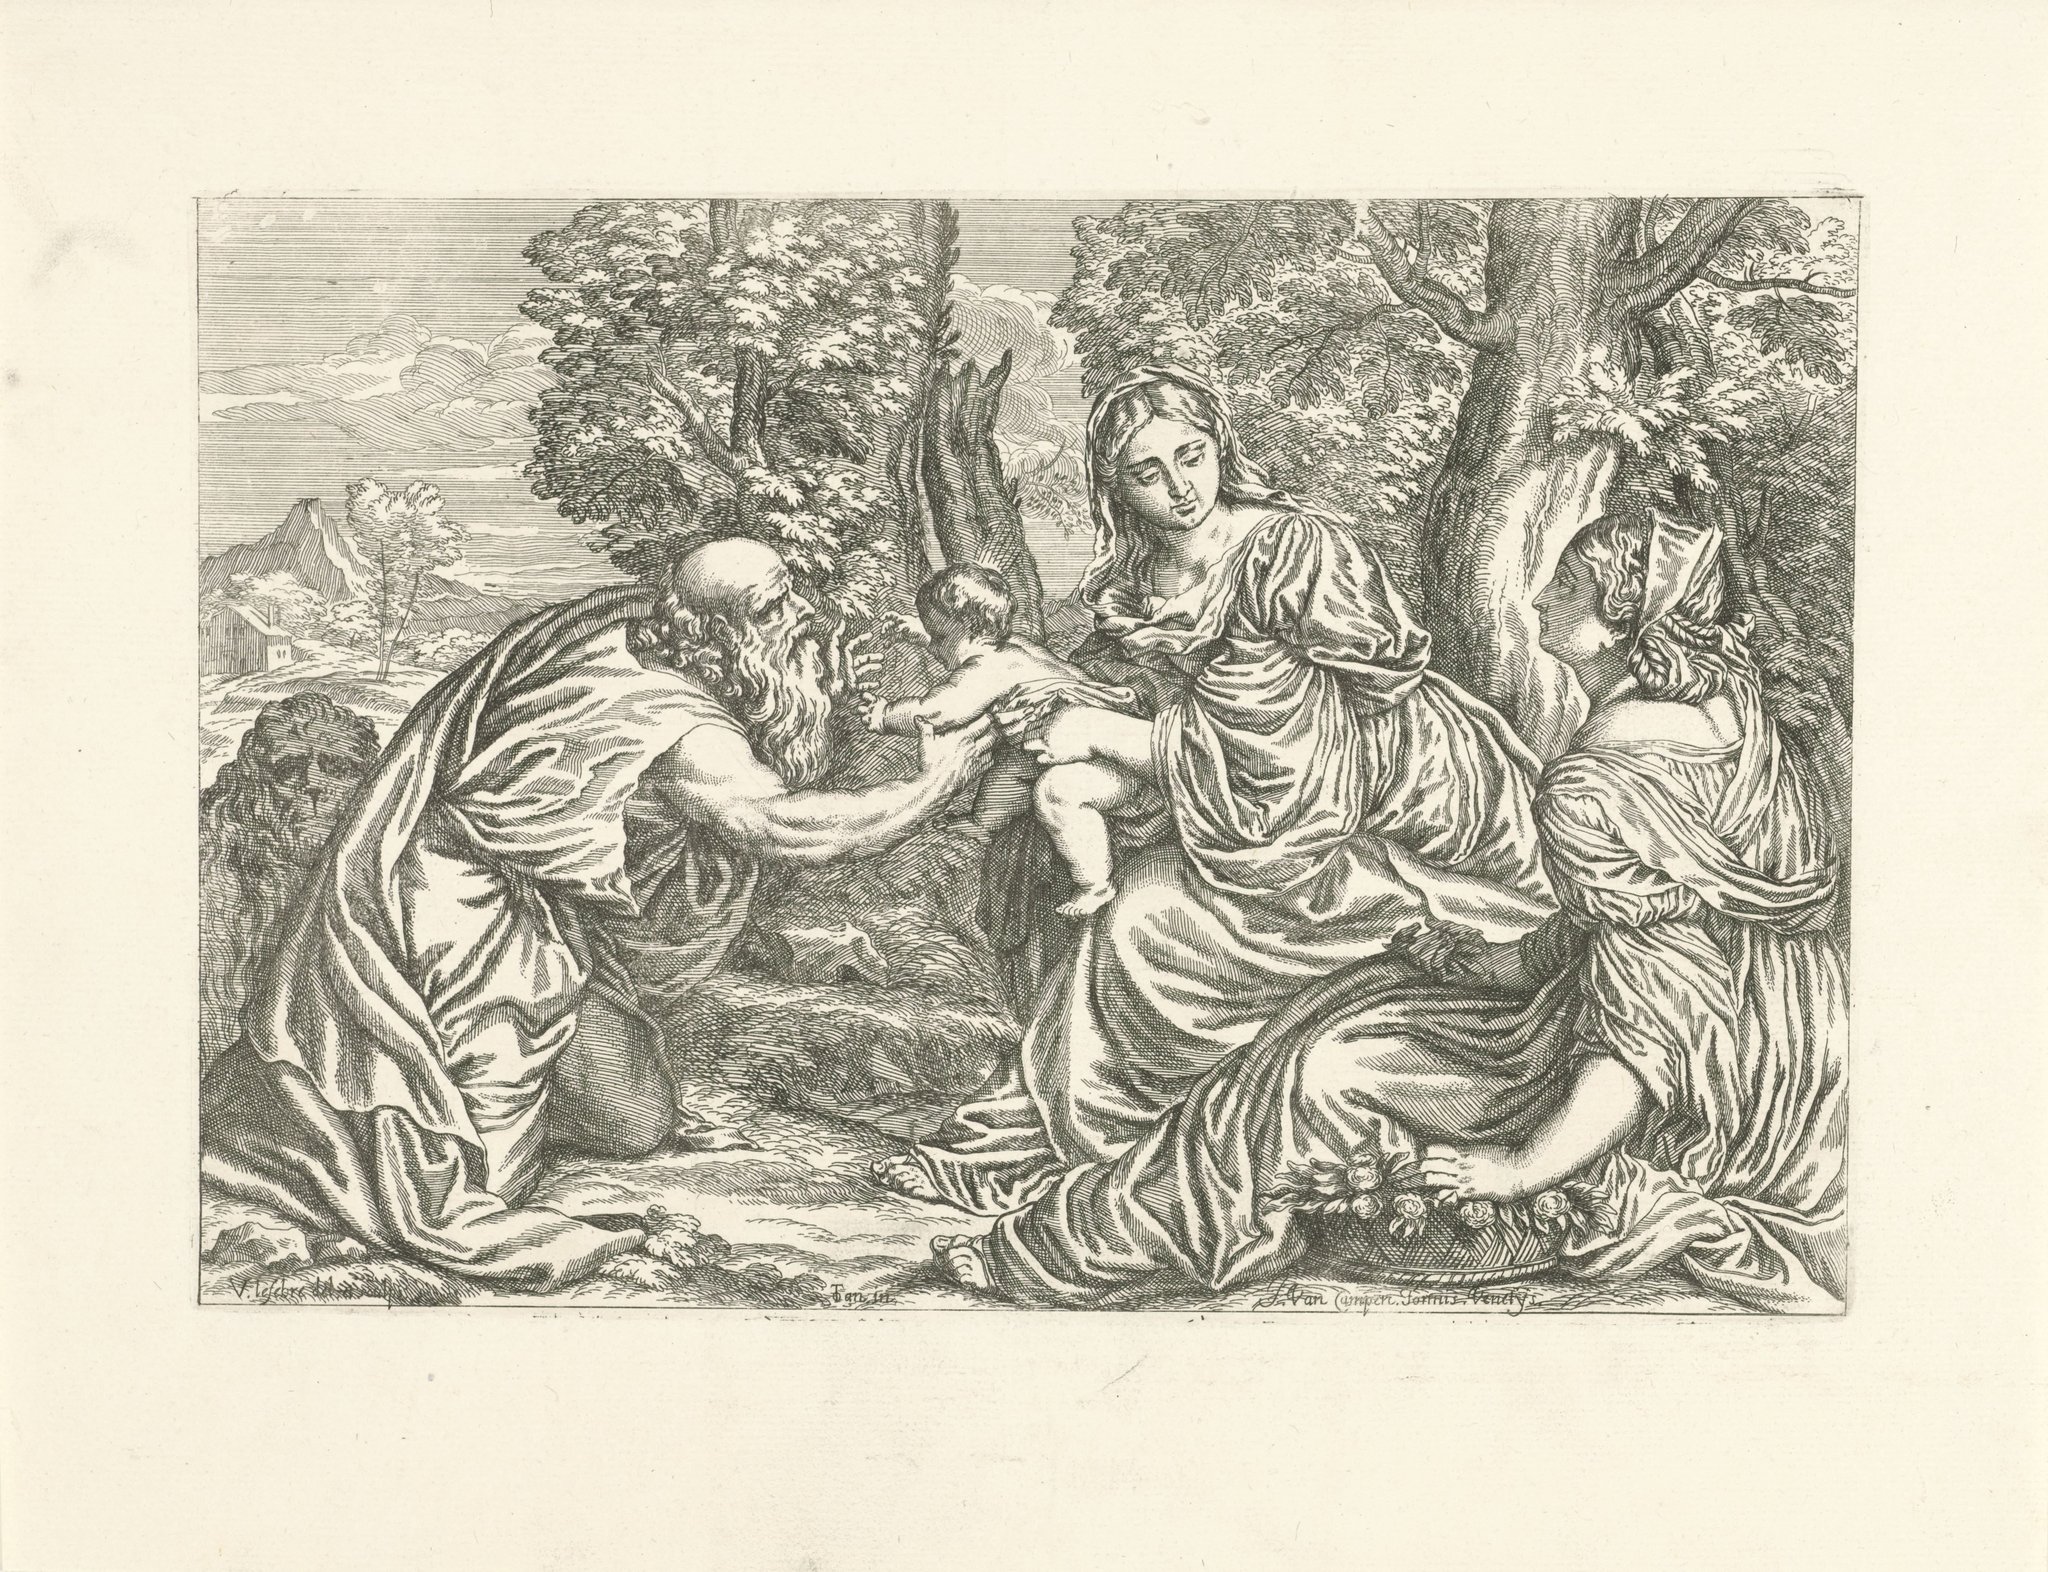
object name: print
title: Maria met het Christuskind en heiligen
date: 1682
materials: paper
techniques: etching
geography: venice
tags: madonna: i.e. mary with the christ-child, the virgin martyr dorothea of caesarea; possible attributes: basket of roses and apples, child with basket of roses, garland of roses, roses in hand or lap, the monk and hermit jerome (hieronymus); possible attributes: book, cardinal's hat, crucifix, hour-glass, lion, skull, stone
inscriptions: collector's mark: Lugt 2228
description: Maria zit al leunend tegen een boom met het Christuskind in haar armen. Links is de heilige Hieronymus, in het gezelschap van een leeuw, voor het kind geknield. Rechts zit de heilige Dorothea met een mand bloemen. De prent maakt deel uit van een 53-delige serie prenten naar schilderijen van Titiaan en Veronese.